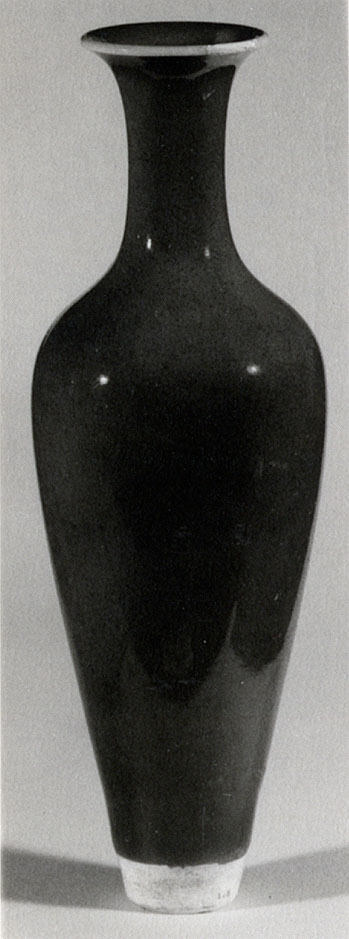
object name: vase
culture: chinese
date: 1713-1722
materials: glaze, porcelain